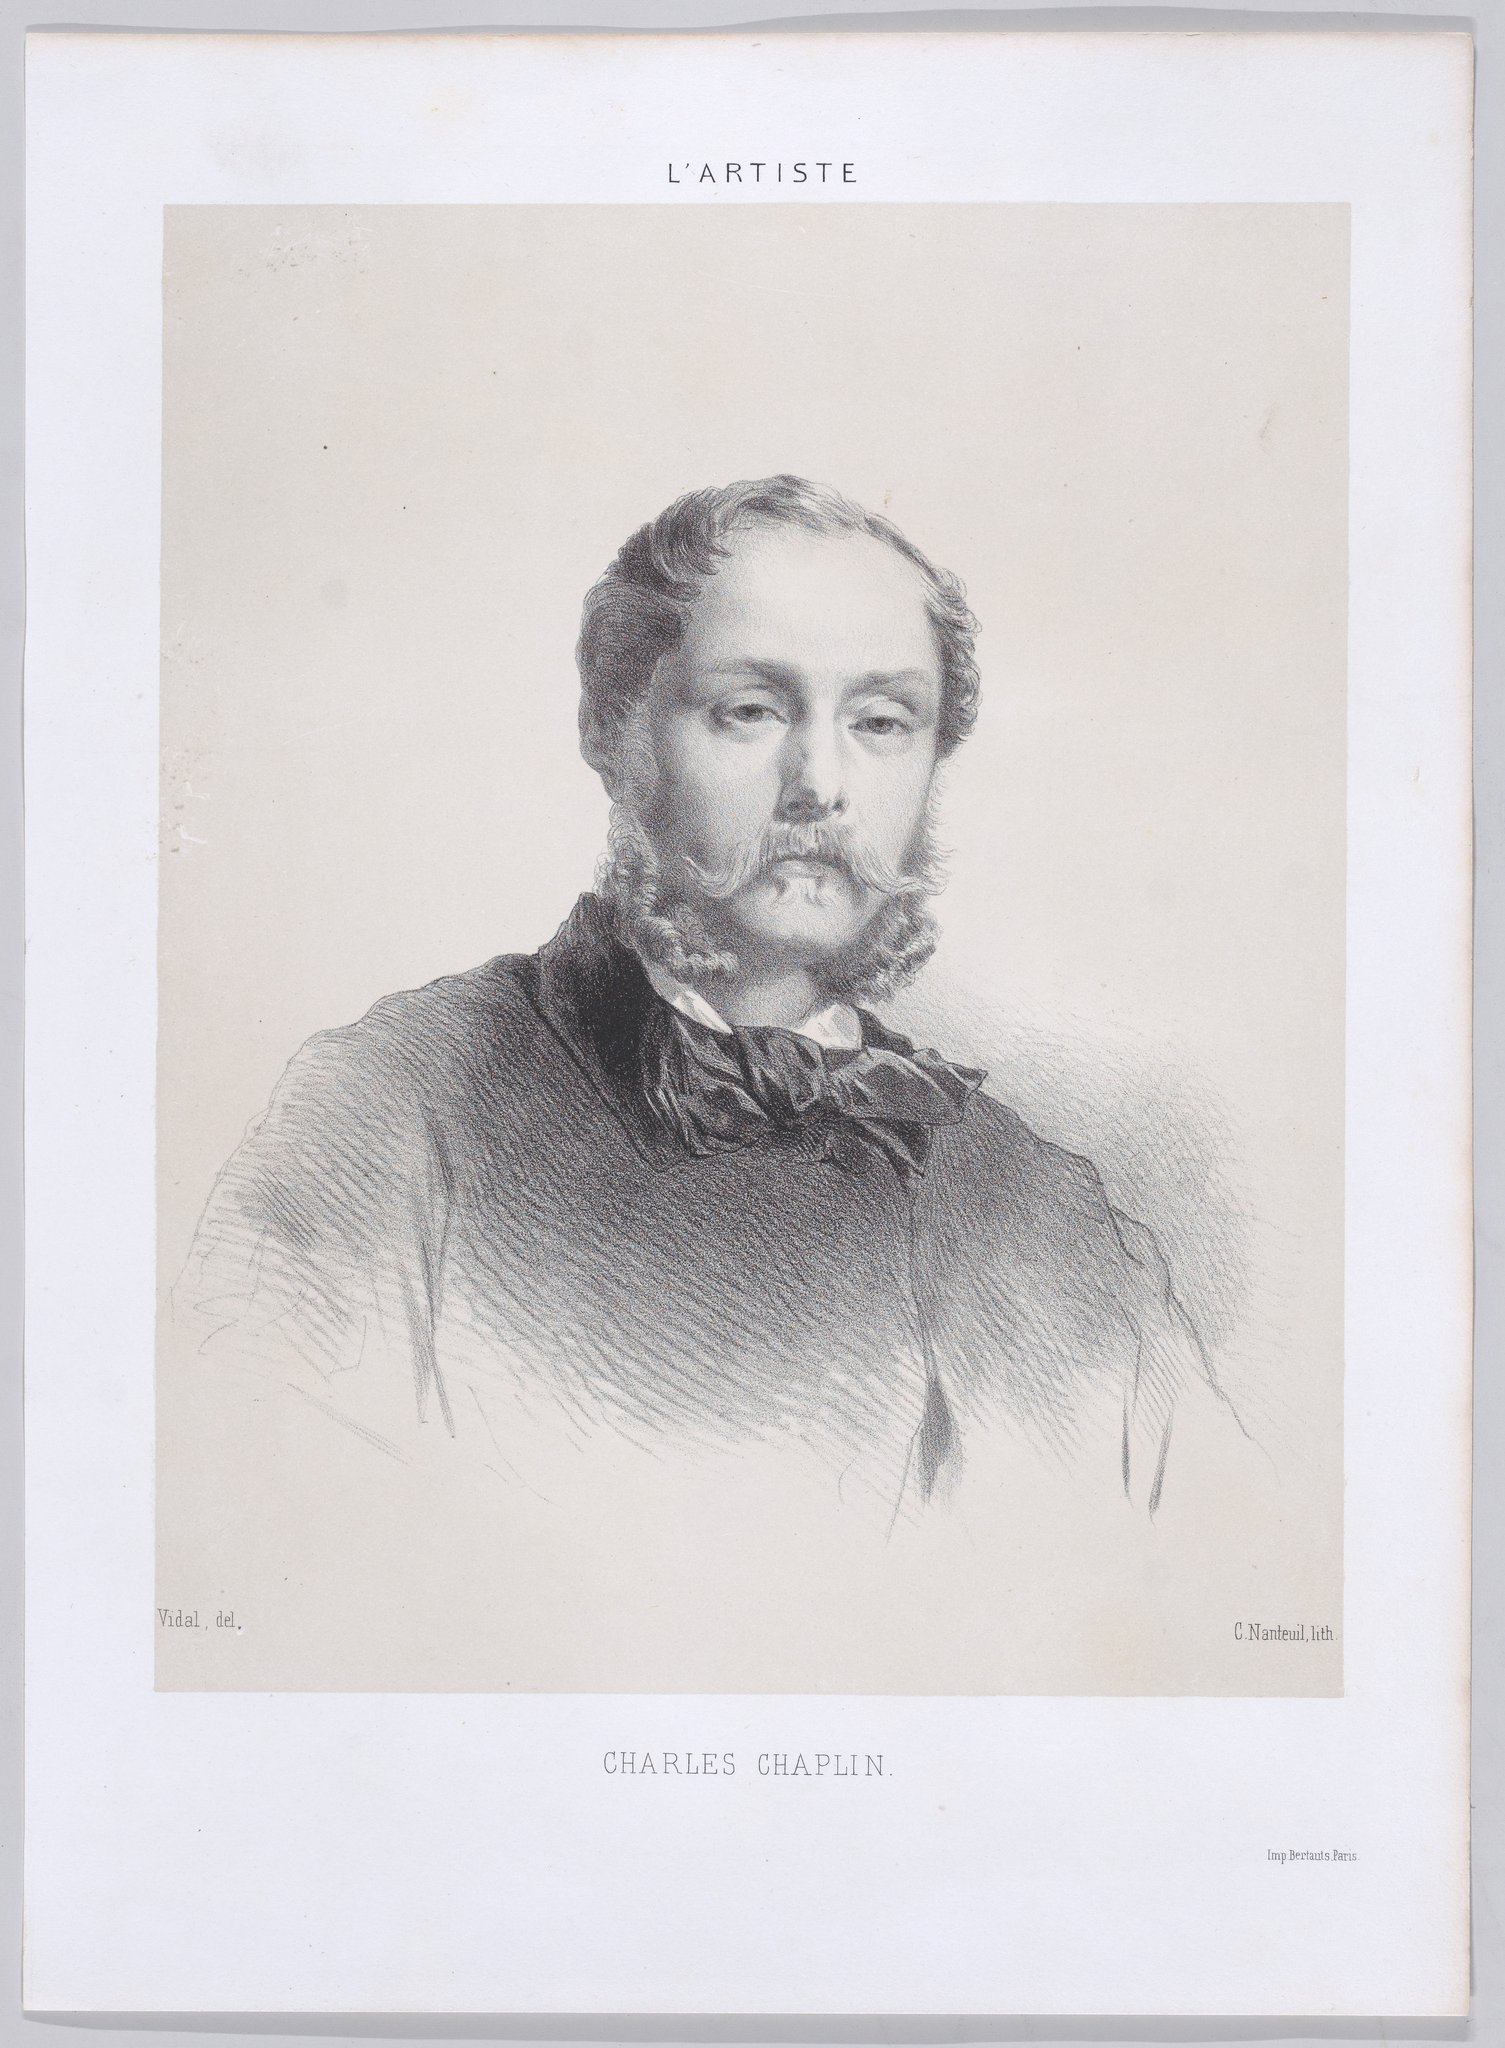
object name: print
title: Charles Chaplin, from "L'Artiste"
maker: célestin nanteuil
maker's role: lithographer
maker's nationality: french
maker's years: 1813-1873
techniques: lithograph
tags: men,portraits,artists